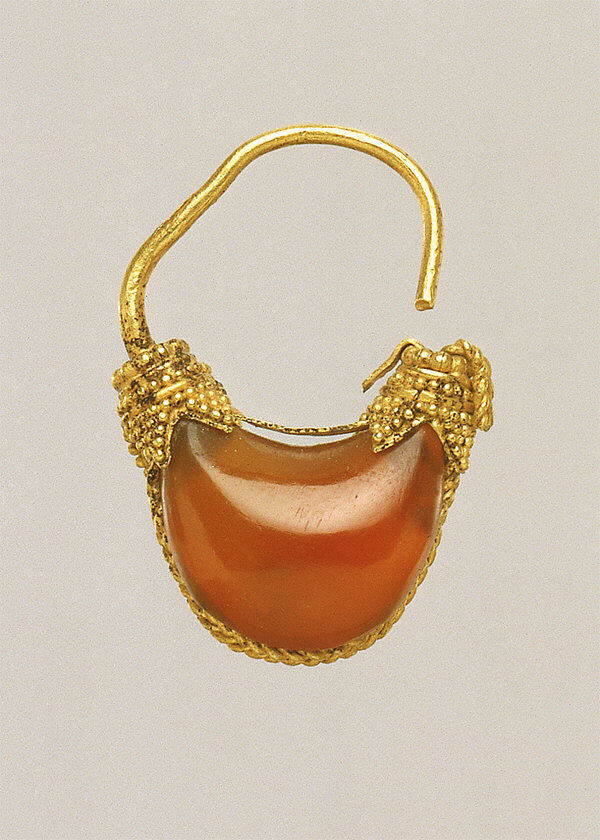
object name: earring, boat shaped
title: Gold and carnelian boat-shaped earring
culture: greek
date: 500-301 BCE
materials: gemstone, gold